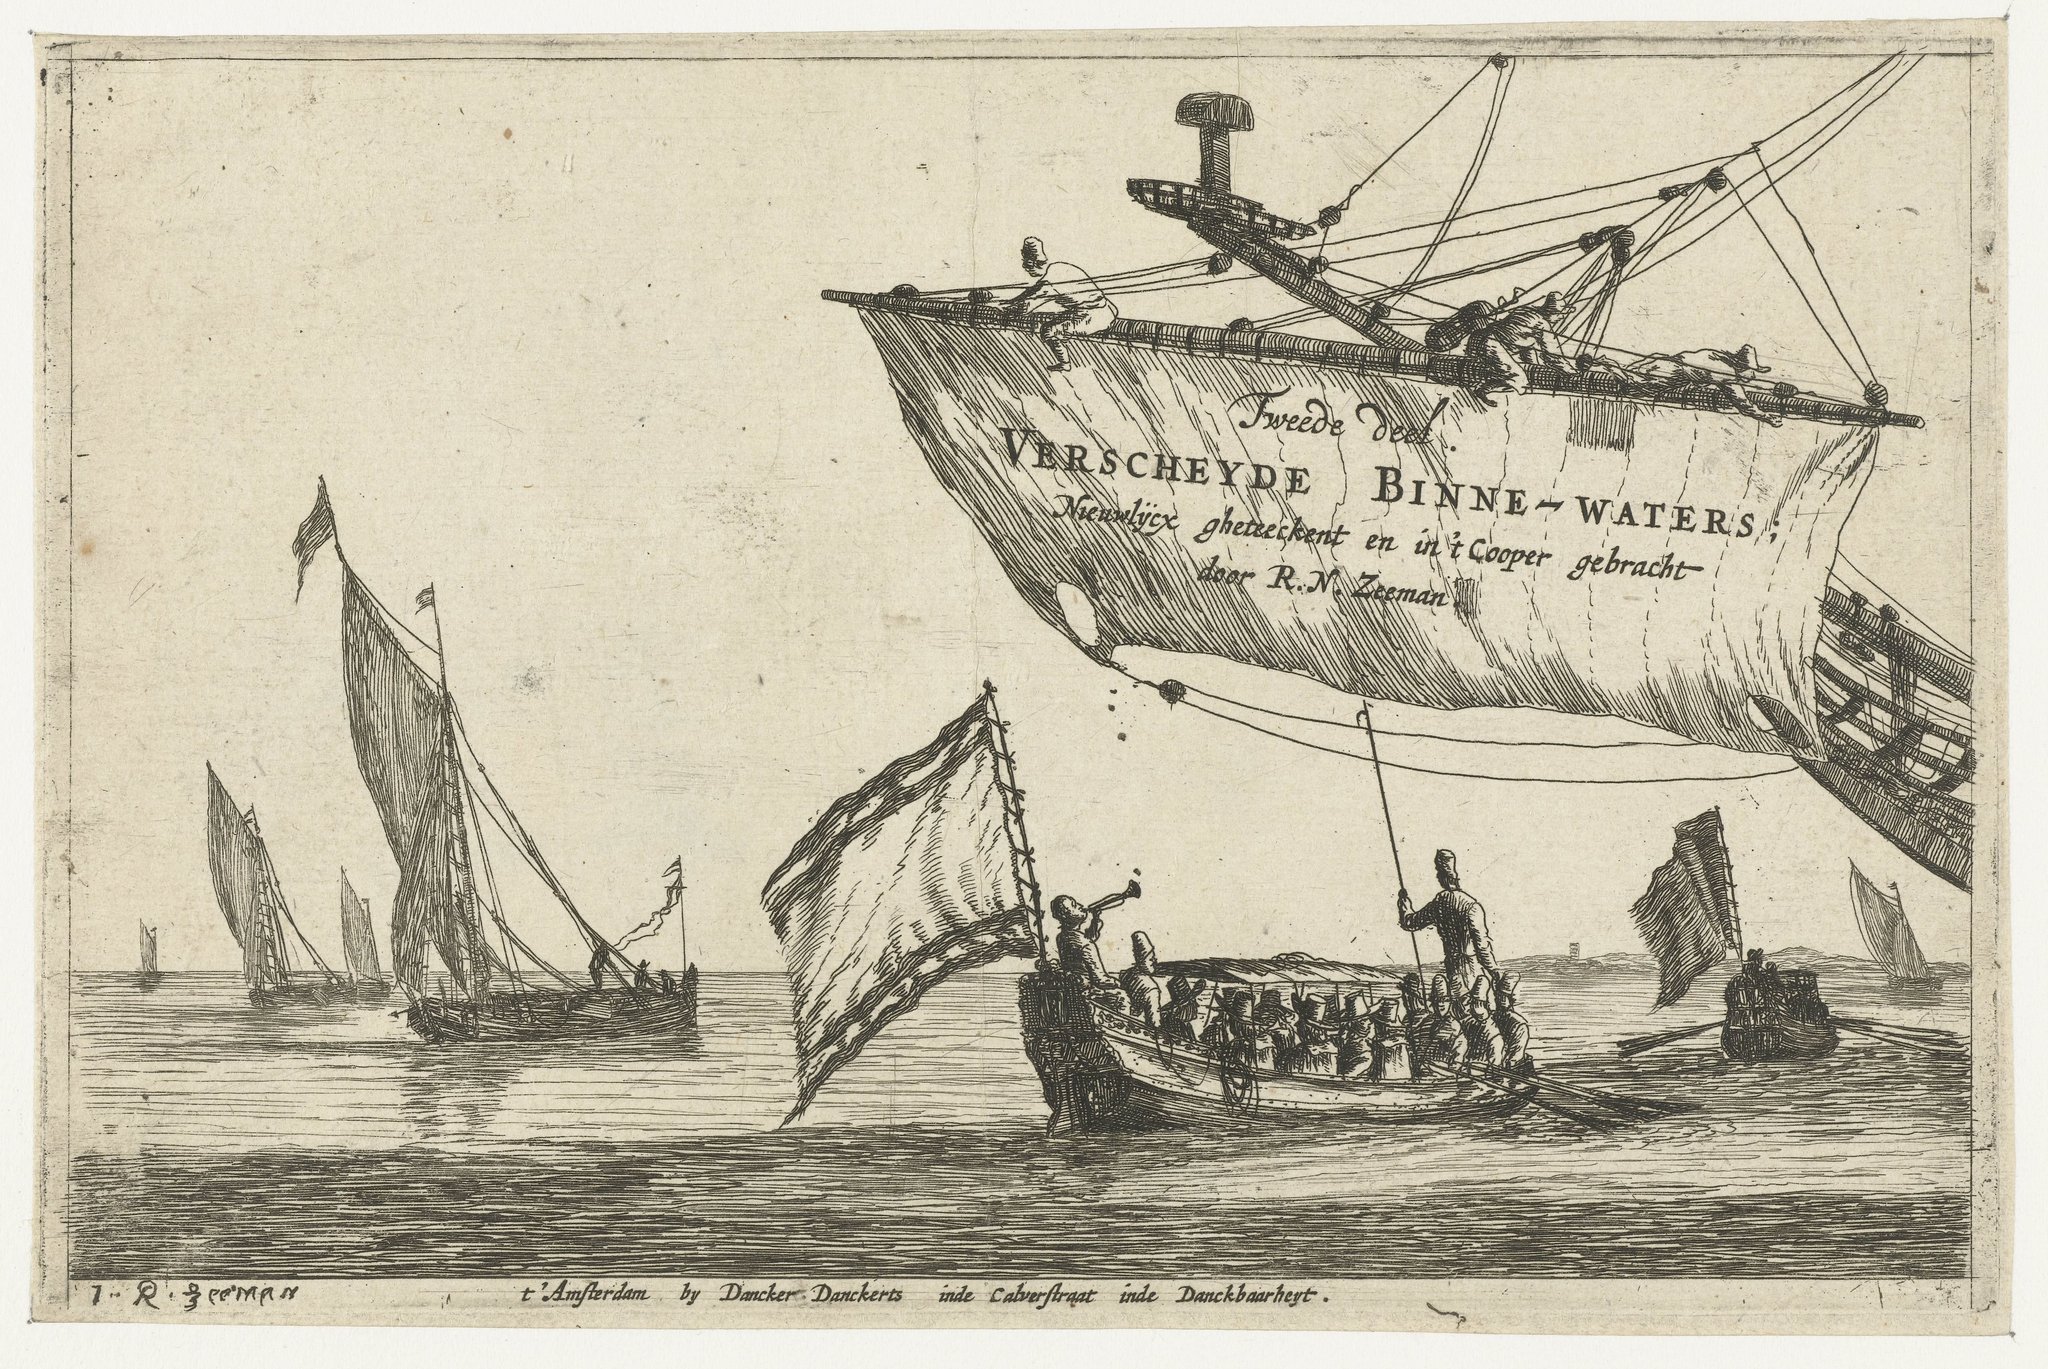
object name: print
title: Binnenwateren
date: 1654-1658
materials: paper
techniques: etching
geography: amsterdam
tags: sailing-ship, sailing-boat, parts of ship's exterior: bow, rowing-boat, canoe, etc.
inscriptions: collector's mark: Lugt 2228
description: Titelblad van een serie van acht prenten. Twee statensloepen, gebruikt om hooggeplaatste figuren te vervoeren, met een baldakijn en een vlag. Een aantal zeilschepen en de boegspriet van een groter zeilschip met een zeil met tekst, drie mannen op de ra.